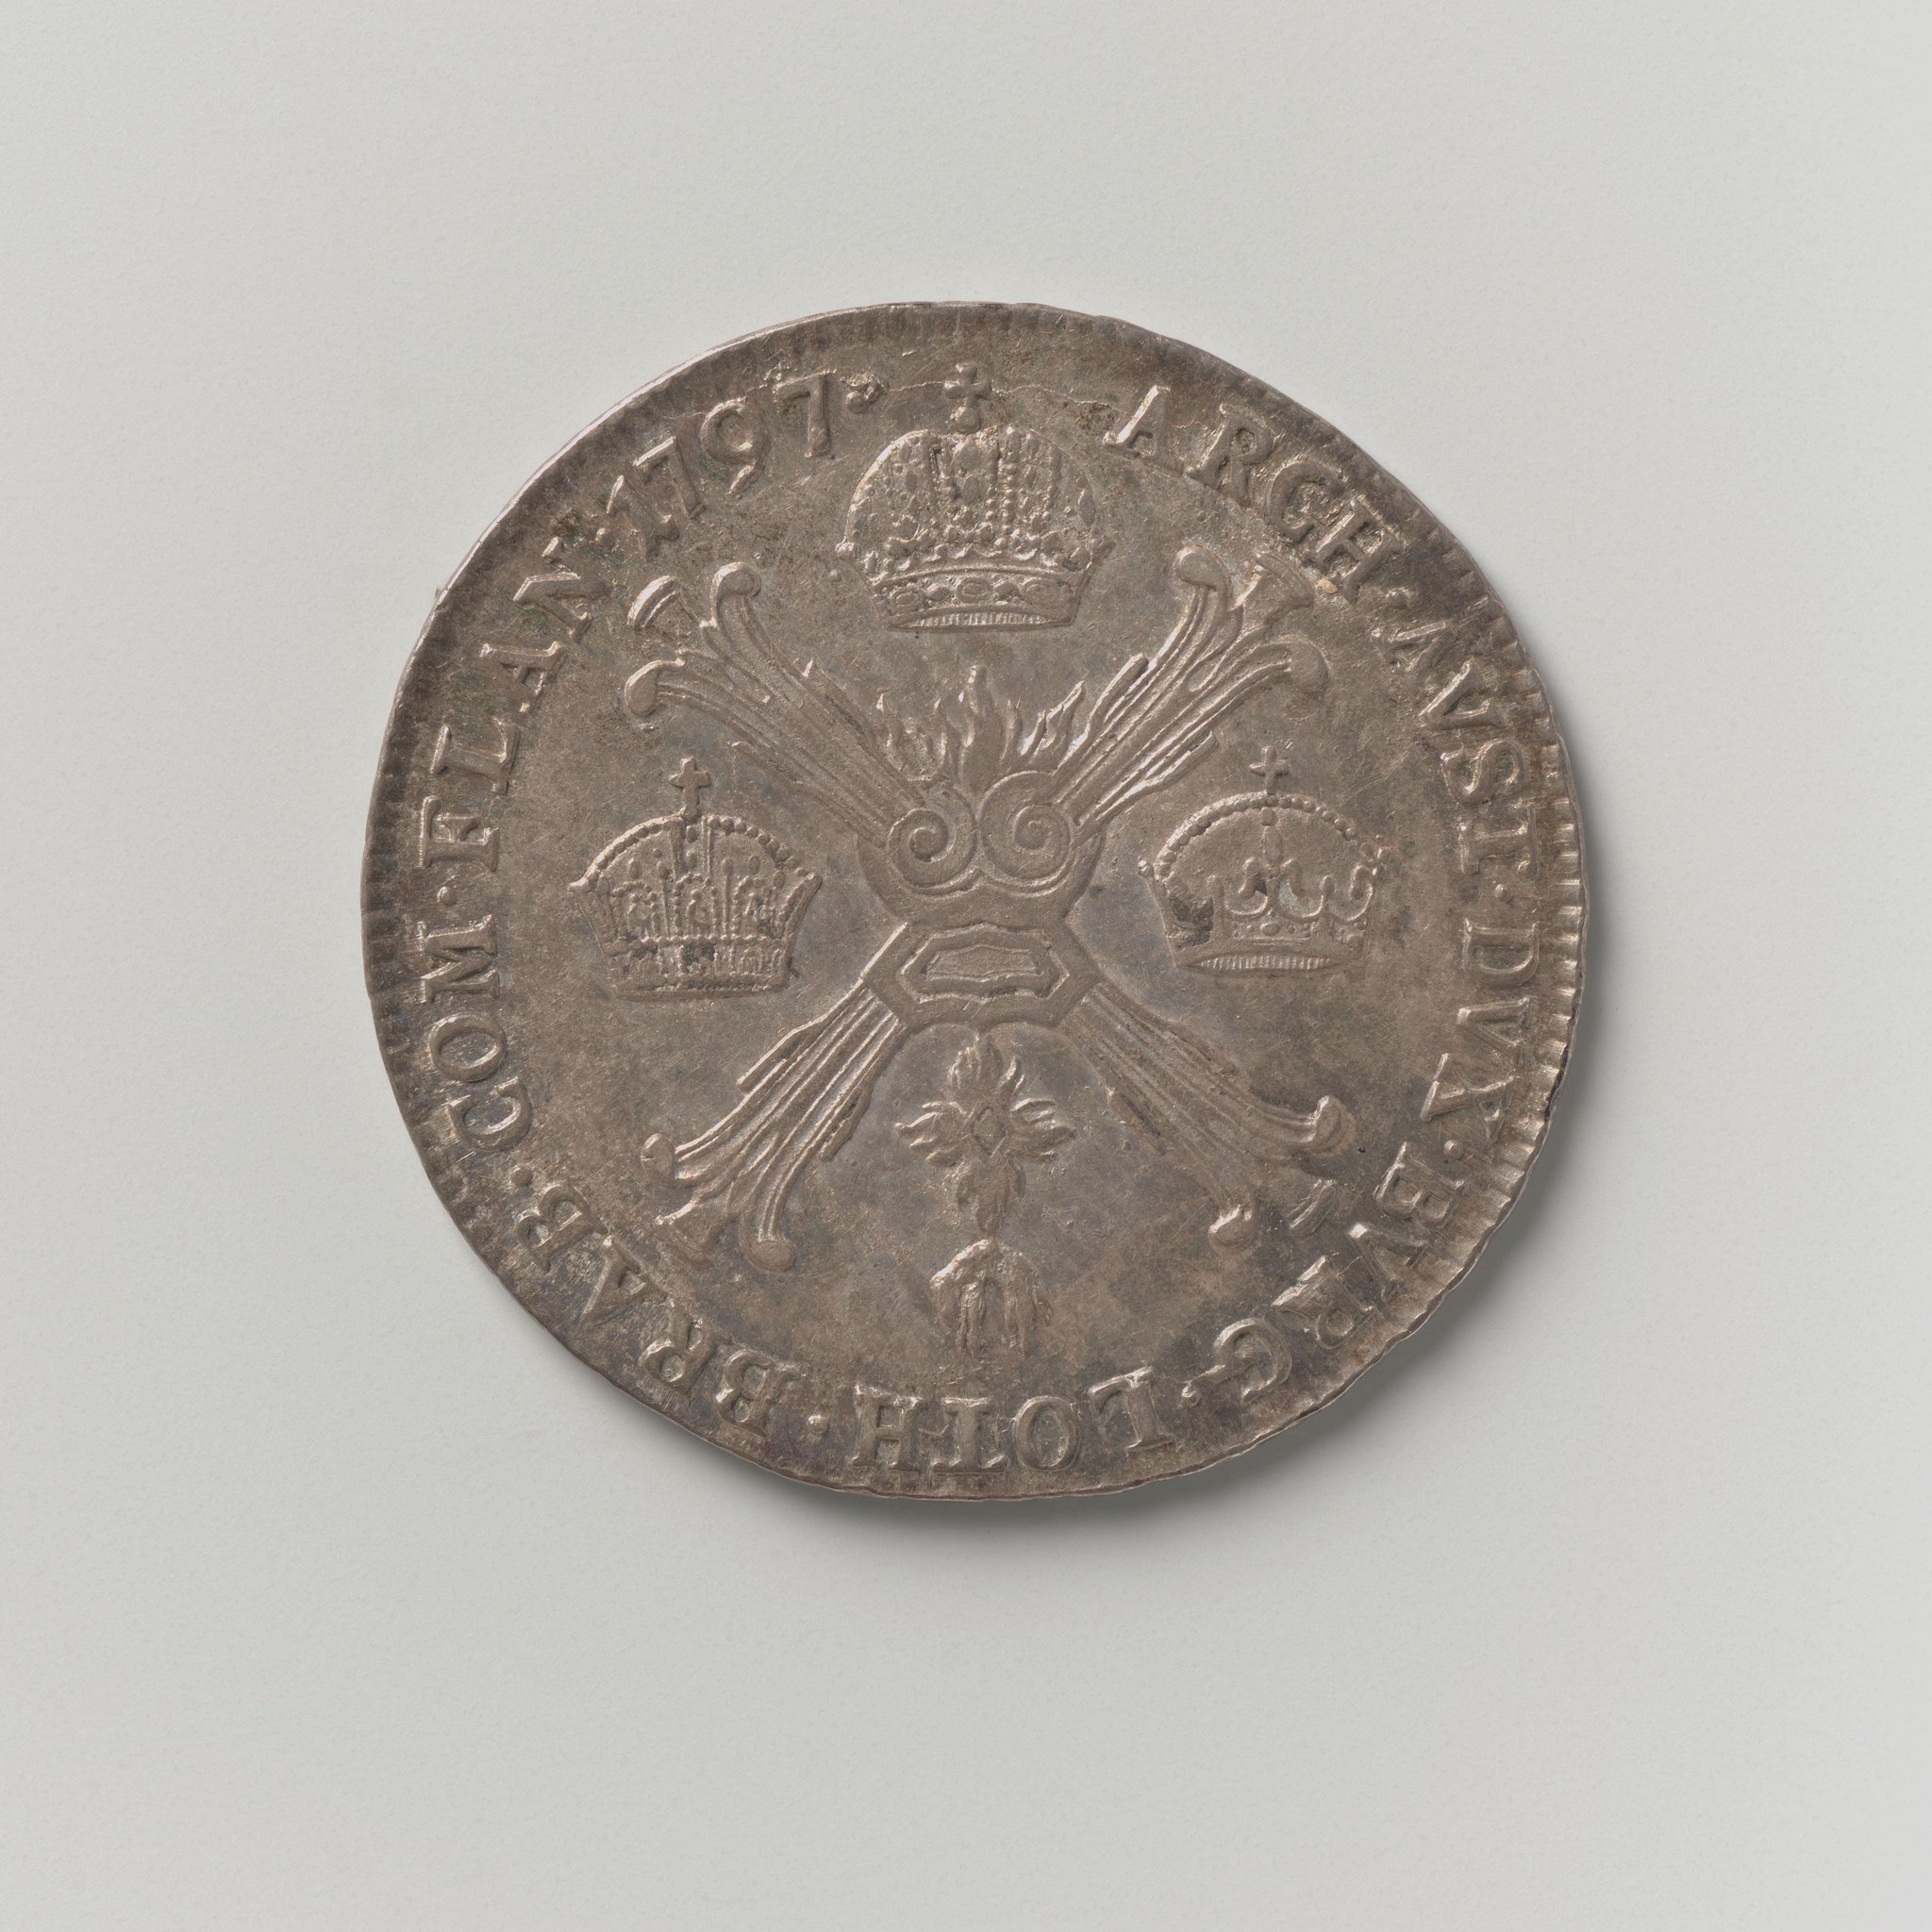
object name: coin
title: Frans II, halve kroon voor Oostenrijkse Nederlanden, 1797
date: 1797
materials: silver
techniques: striking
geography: kremnica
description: Zilveren munt. Voorzijde: stokkenkruis. In de hoeken kronen. Jaartal in omschrift. Keerzijde: portret van Frans II naar rechts. Onder portret letter B [=Kremnitz]. Kabelrand.